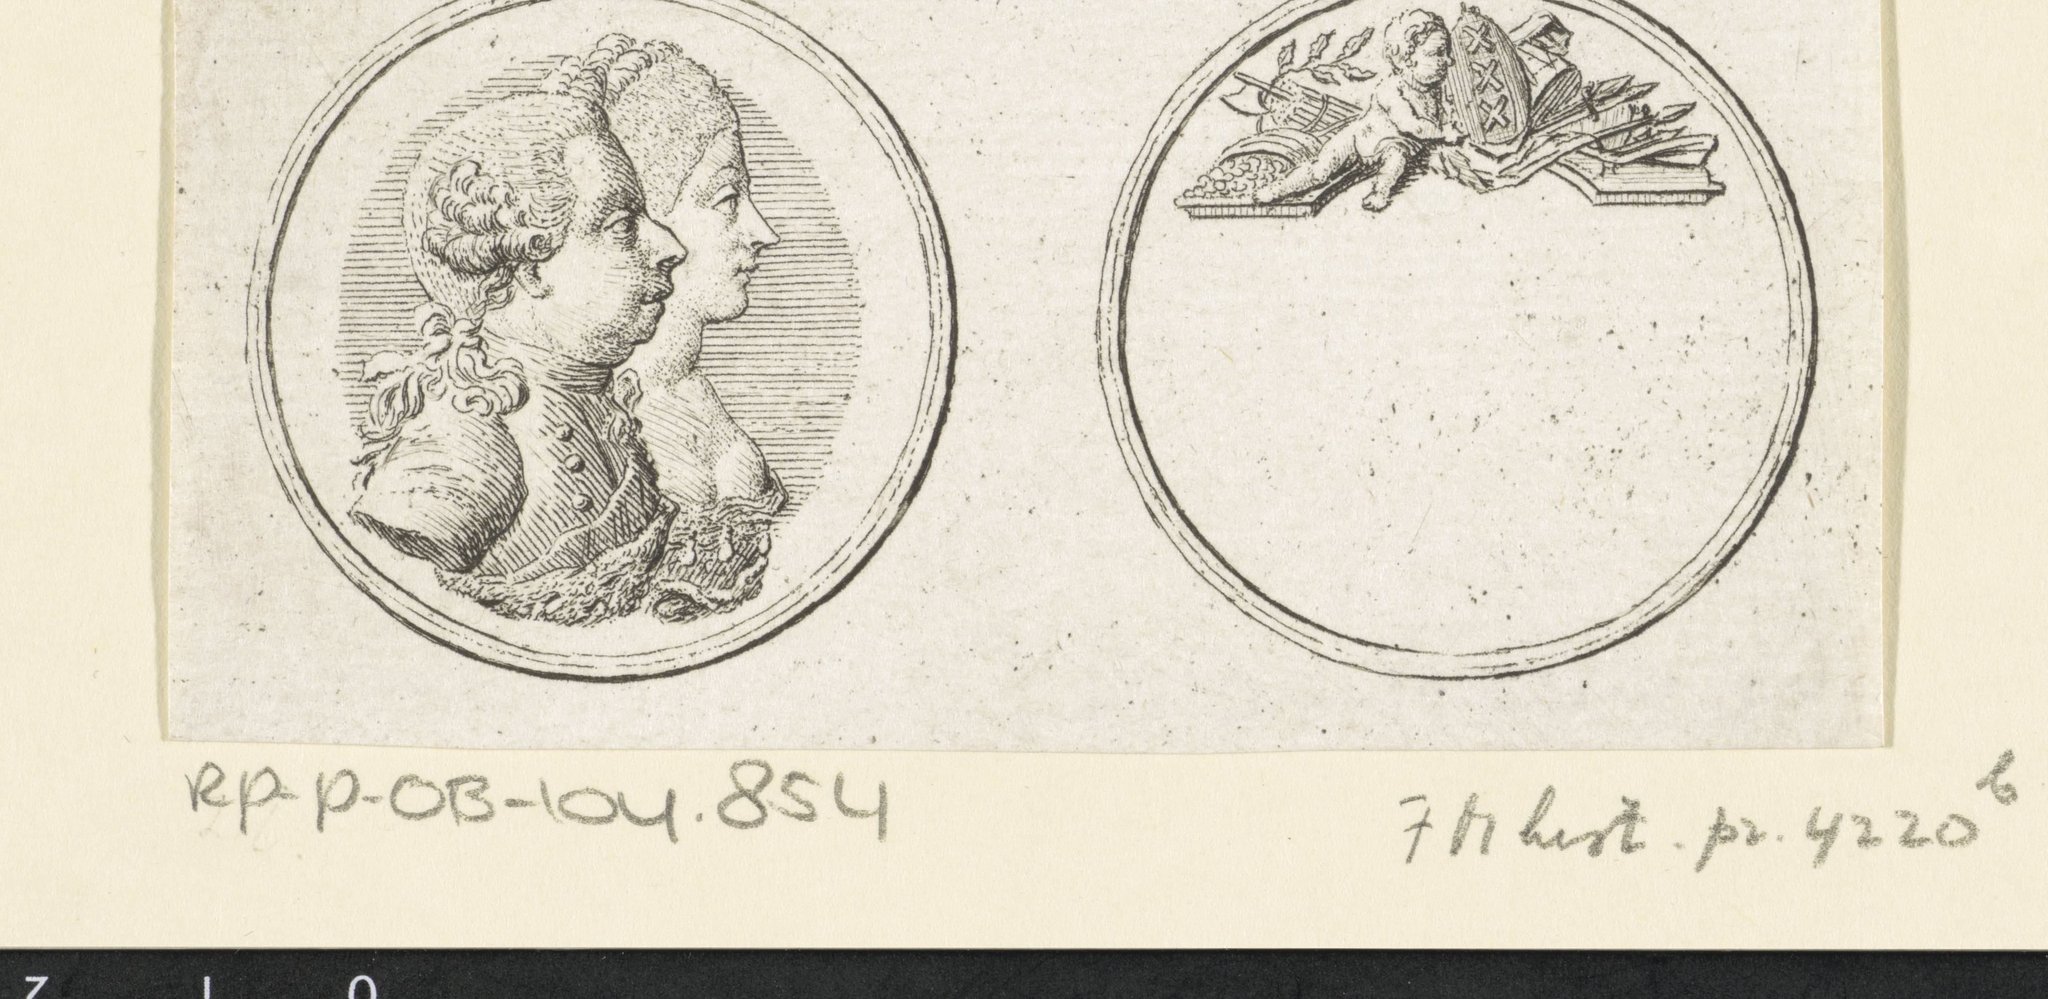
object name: print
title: Penning met portret van Willem V, prins van Oranje-Nassau, en Wilhelmina van Pruisen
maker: Anonymous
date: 1768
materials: paper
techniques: engraving, etching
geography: low countries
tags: william v (prince of orange), berlin, painter, draughtsman, wilhelmina of prussia (princess of orange), amsterdam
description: De hier vermelde titel verwijst naar de hoogst verkregen titel van de geportretteerde, niet per se naar de titel die de geportretteerde op deze voorstelling draagt. Voor de penning zie objectnummer BK-VBR-108 in de collectie van het Rijksmuseum.